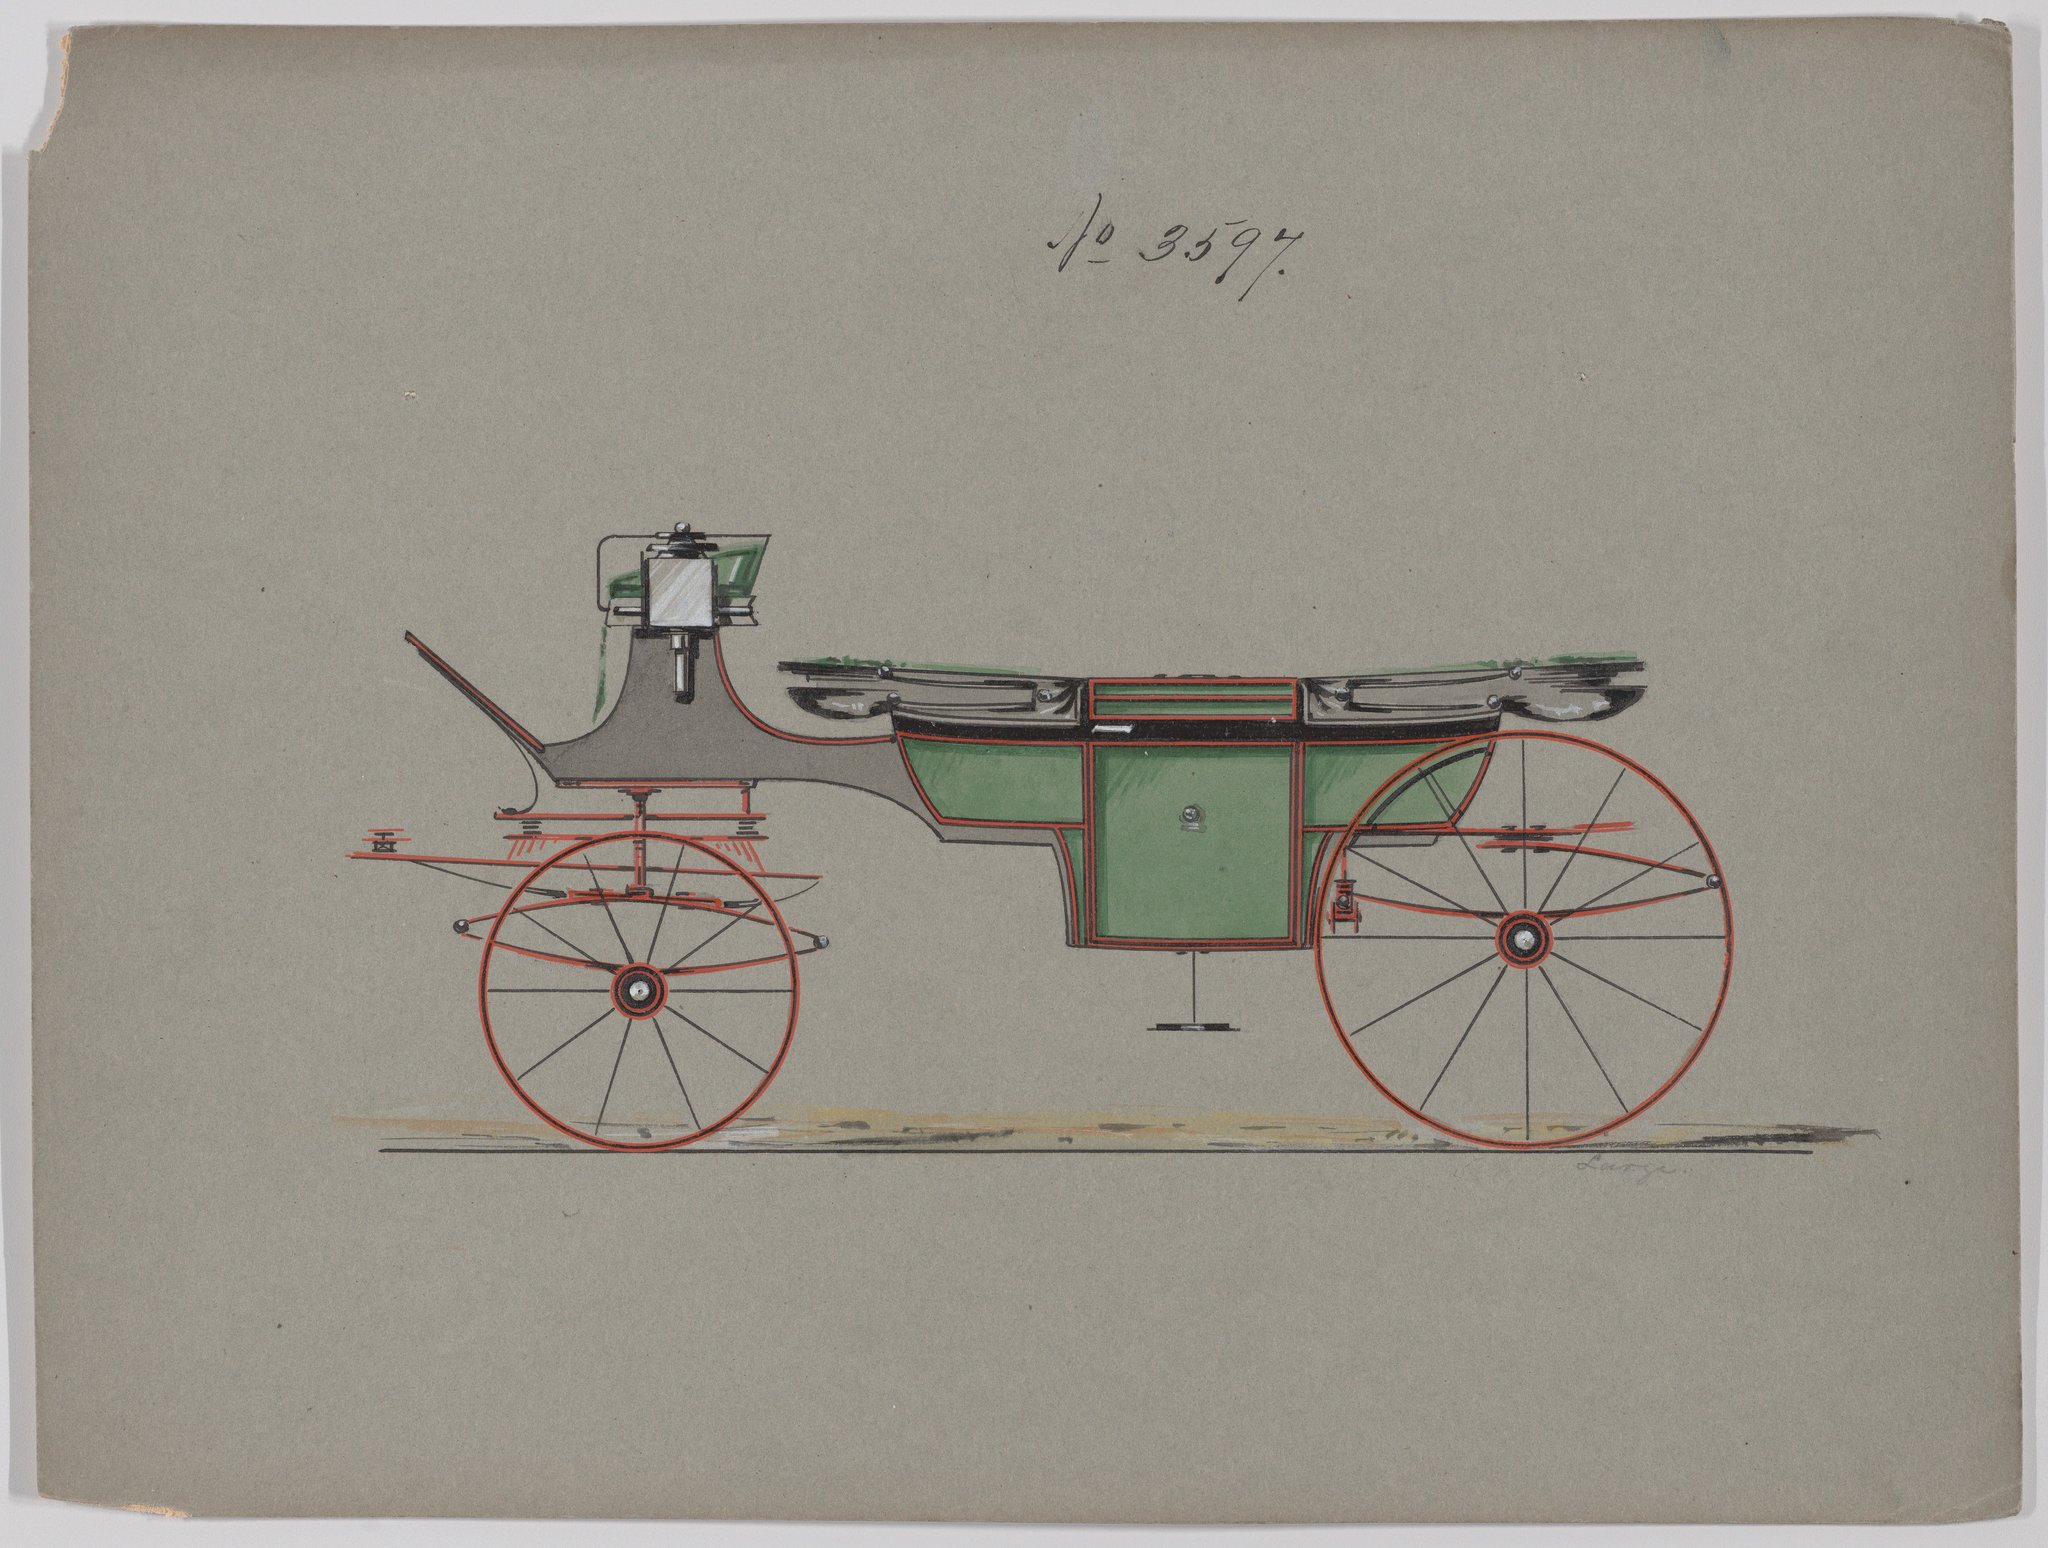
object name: drawing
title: Design for Landau, No. 1597 (or 3597?)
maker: brewster & co.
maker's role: manufacturer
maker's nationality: american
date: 1880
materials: gouache, gum arabic, ink, watercolor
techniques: pen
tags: carriages